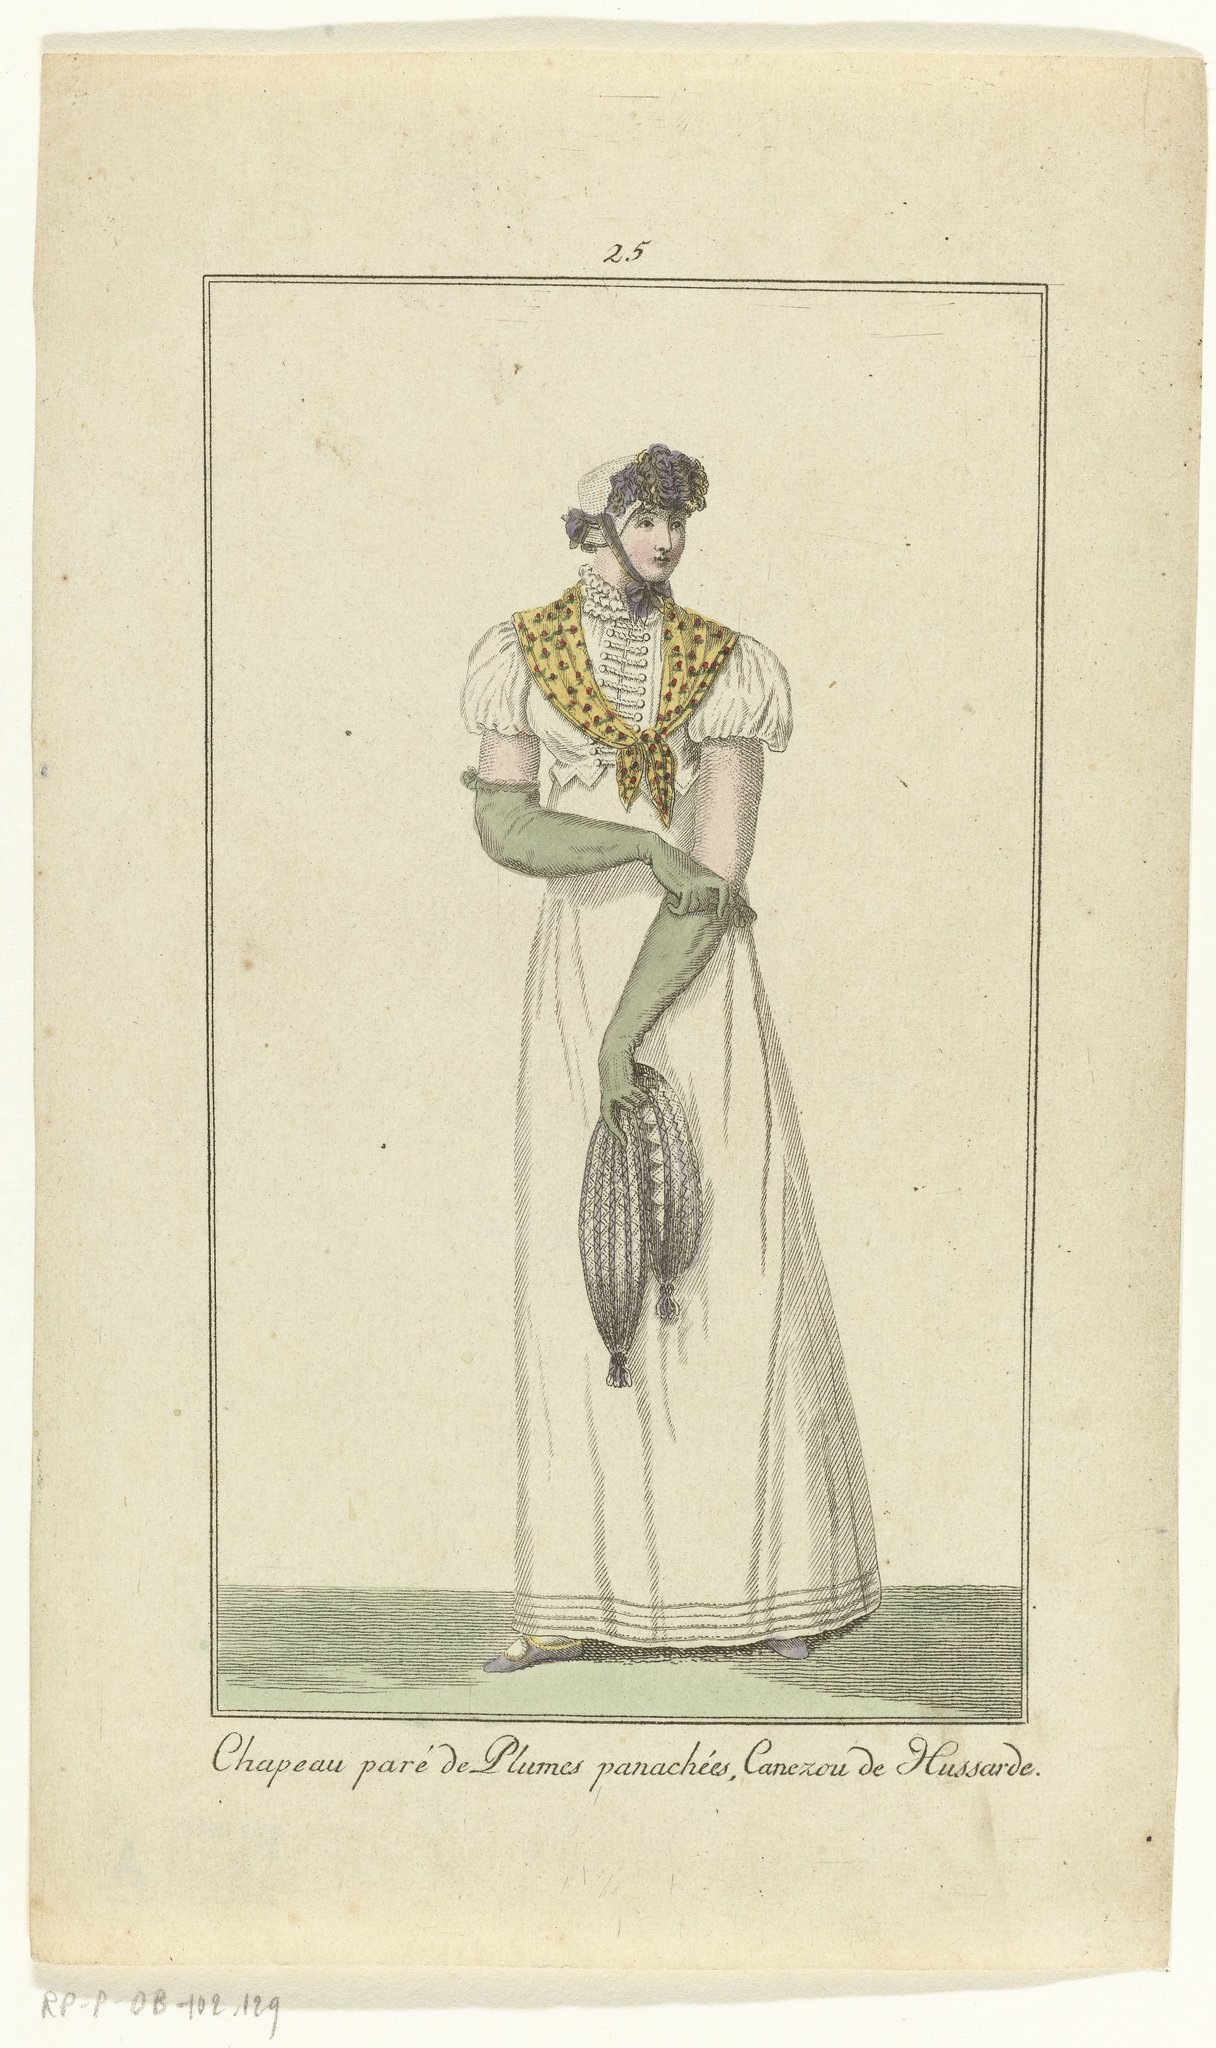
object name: fashion print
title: Elegantia, of tijdschrift van mode, luxe en smaak voor dames, Oktober 1807, No. 25 : Chapeau paré de Plumes panachées...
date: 1807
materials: paper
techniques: engraving, hand coloring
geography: amsterdam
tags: gloves, mittens (long gloves) (+ women's clothes), clothing for the upper part of the body (shawl) (+ women's clothes), head-gear (straw hat) (+ women's clothes), fashion plates, shoes, sandals (+ women's clothes), dress, gown (+ women's clothes), piece of clothing covering the breast or décolleté (fichu) (+ women's clothes)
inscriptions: caption: ‘Chapeau paré de Plumes panachées. Canezou de Hussarde.’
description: Volgens de beschrijving in het tijdschrift (p. 328): Japon van witte mousseline. 'Canezou à la Hussarde'. 'Fichu van wol; witte strohoed met veren. Sjaal genaamd 'Zéphyre'. Pistache kleurige handschoenen. Lilakleurige satijnen schoenen. Prent uit het modetijdschrift Elegantia, of tijdschrift van mode, luxe en smaak voor dames 1807-1814 (onderbroken door de periode 1811-1813).